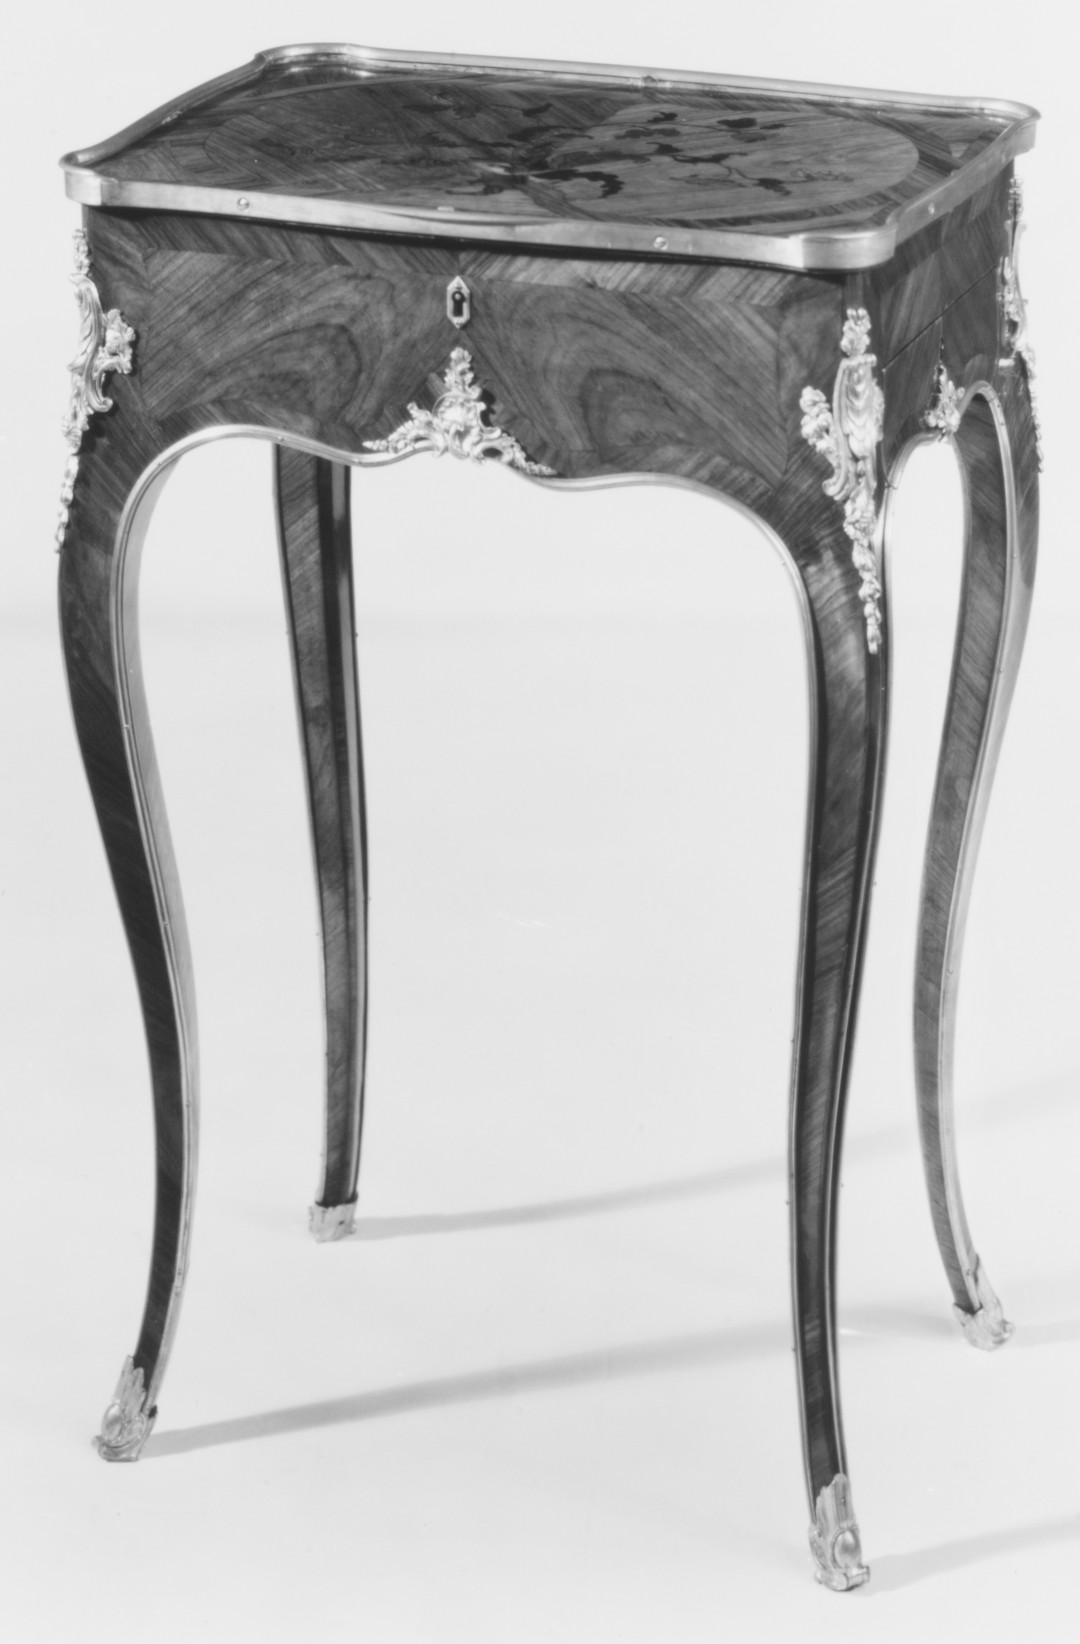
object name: work and writing table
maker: bernard ii van risenburgh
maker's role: maker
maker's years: 1696-1767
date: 1755-1760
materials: gilt bronze, metal, wood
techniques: cutting, silvered